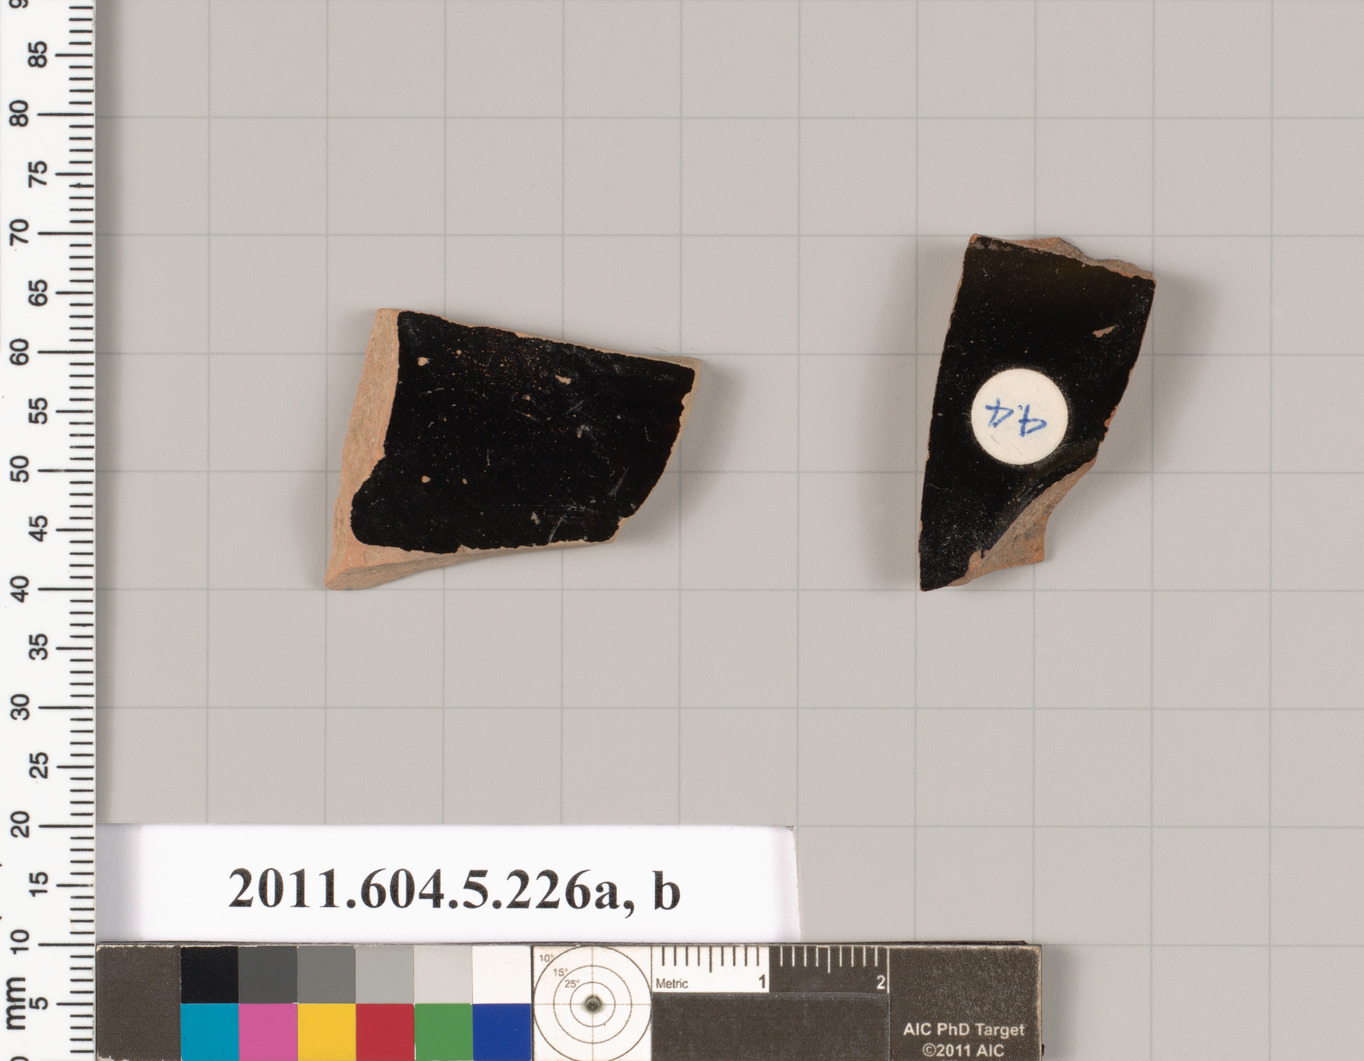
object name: kylix fragment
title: Terracotta fragments of kylikes (drinking cups)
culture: greek, attic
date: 600-401 BCE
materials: terracotta